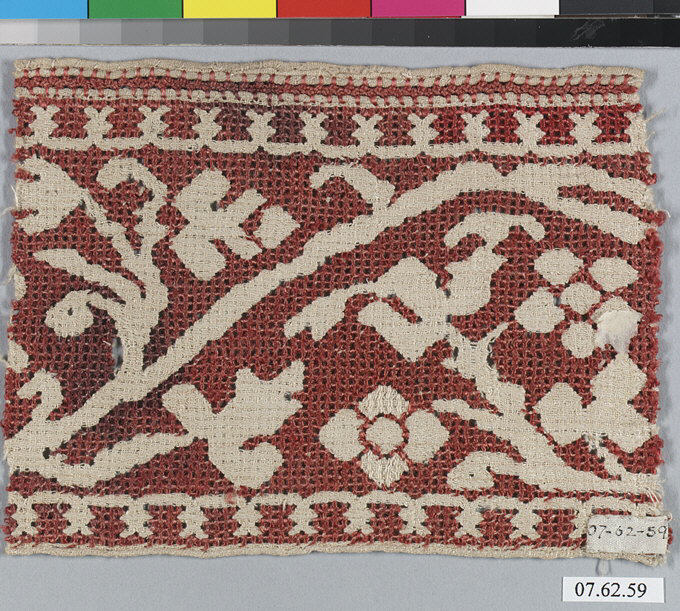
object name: fragment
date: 1501-1700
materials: linen, silk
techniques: embroidery